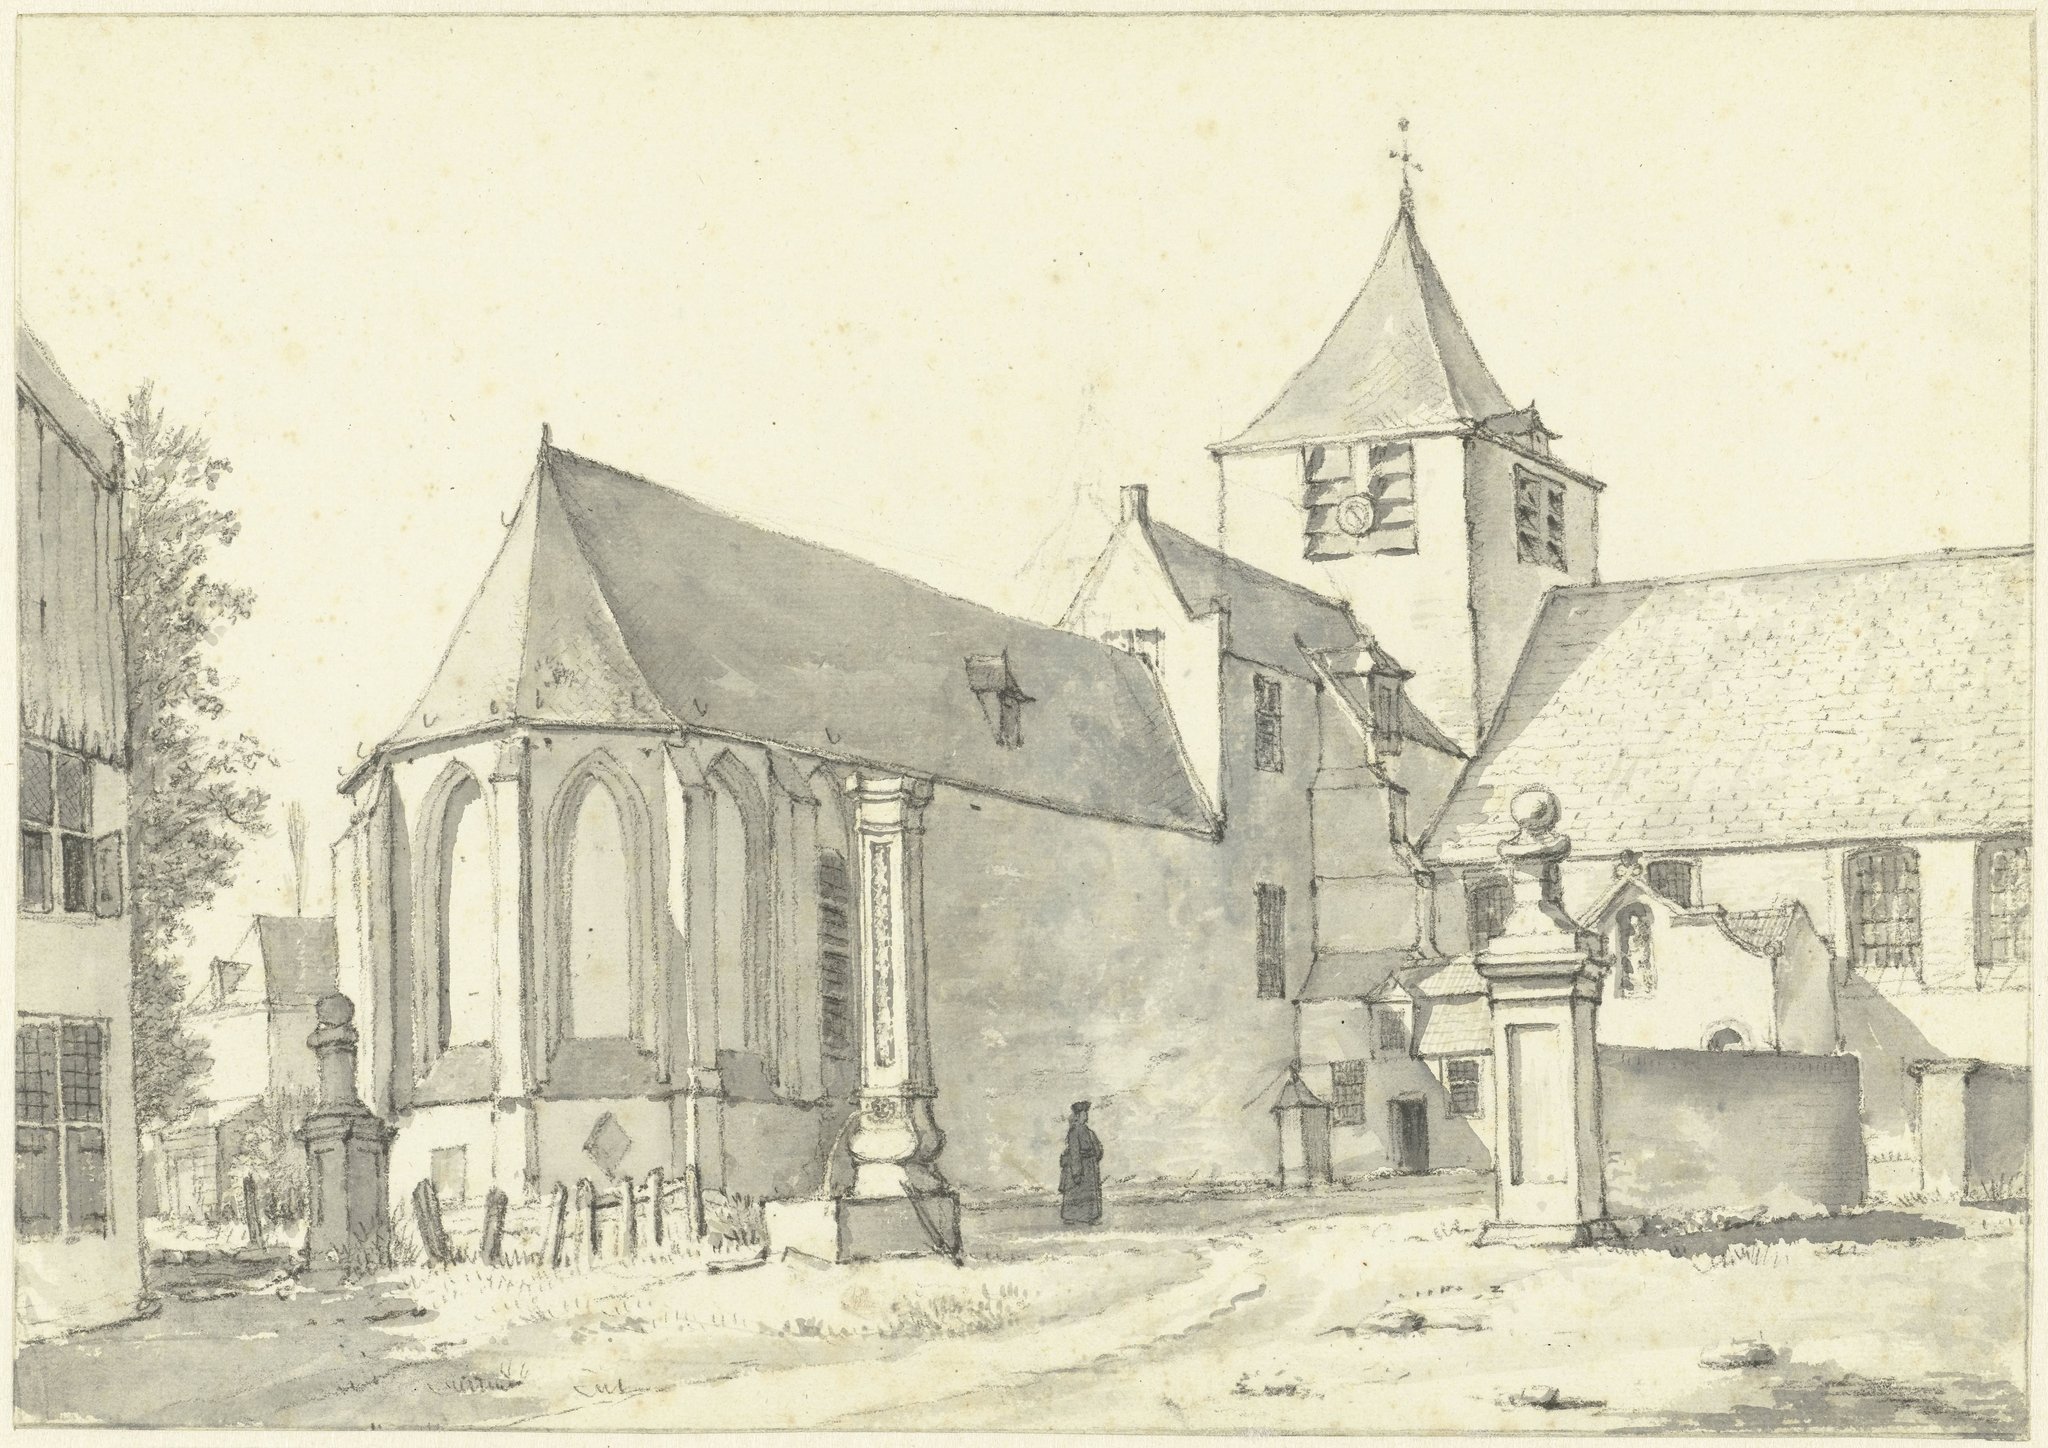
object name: drawing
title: De kerk te Laeken bij Brussel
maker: gerrit lamberts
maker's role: bookseller, draughtsman, print maker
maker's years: 1776-1850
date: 1786-1850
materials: chalk, paper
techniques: brush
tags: church (exterior), laeken